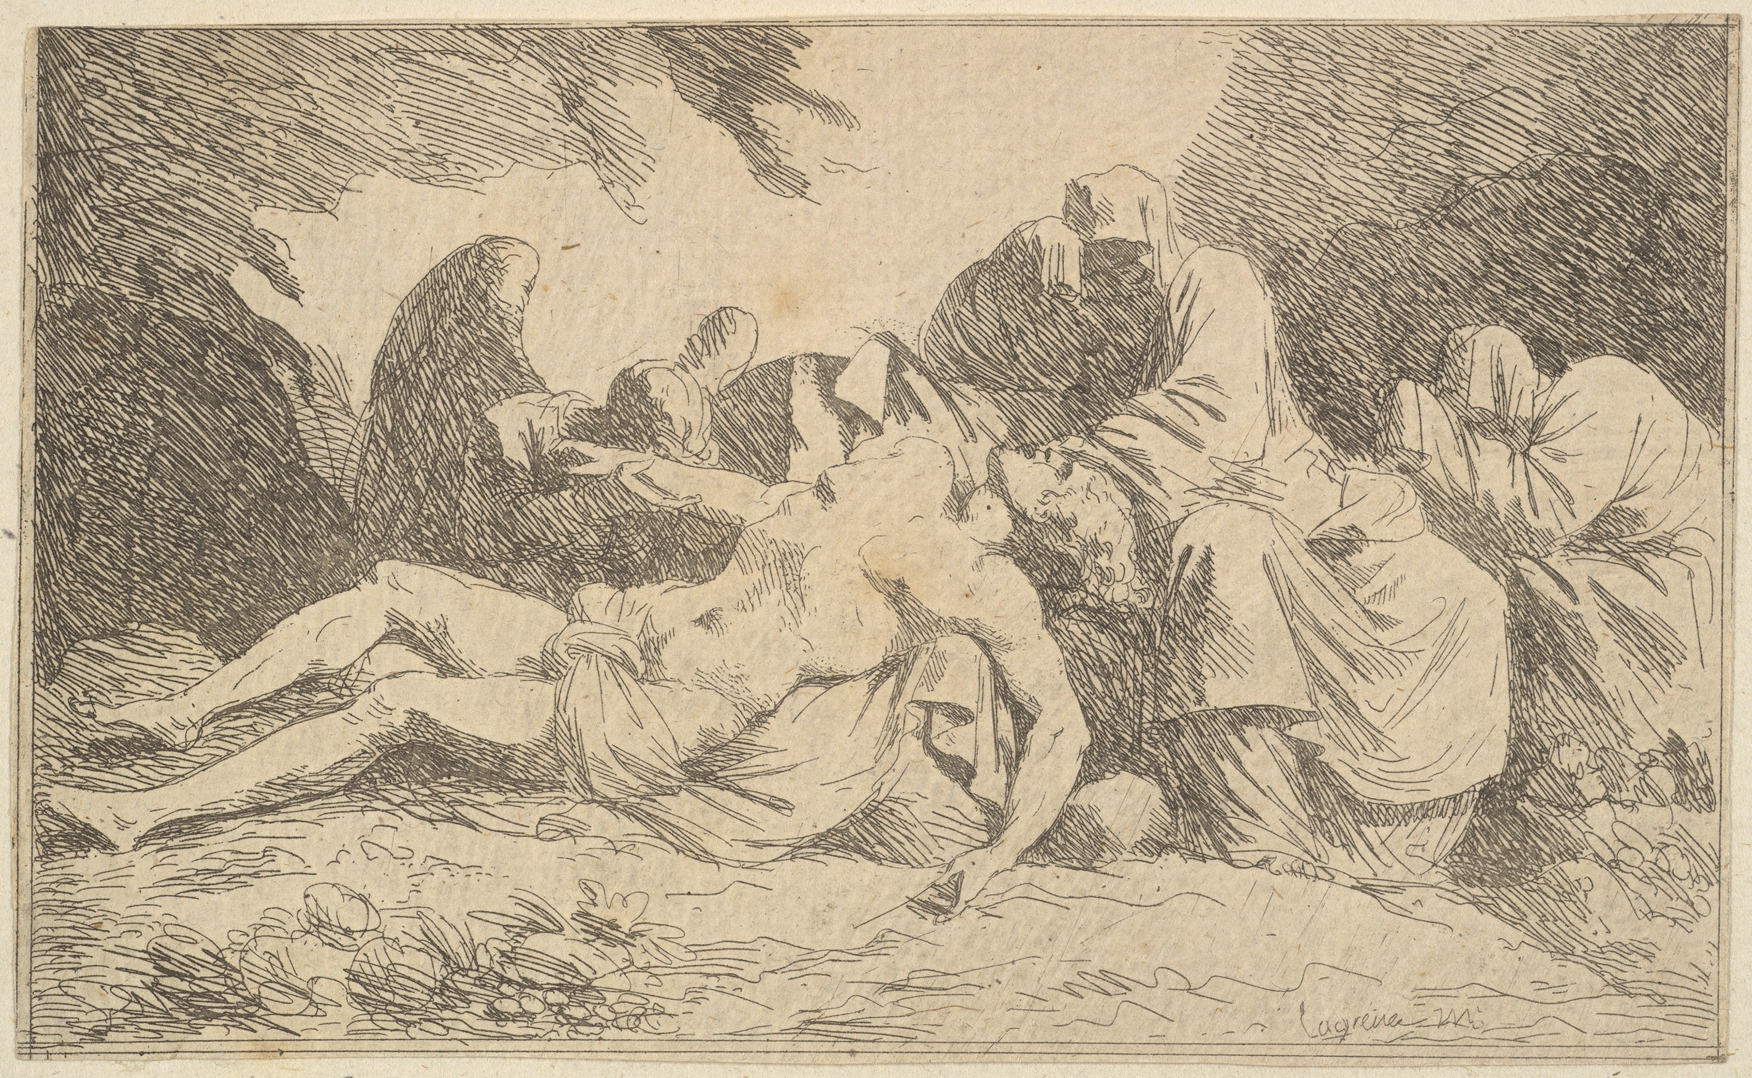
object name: print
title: Le Christ au tombeau (The Entombment)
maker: jean jacques lagrenée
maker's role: artist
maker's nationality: french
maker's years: 1739-1821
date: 1762-1763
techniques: etching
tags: christ,entombment